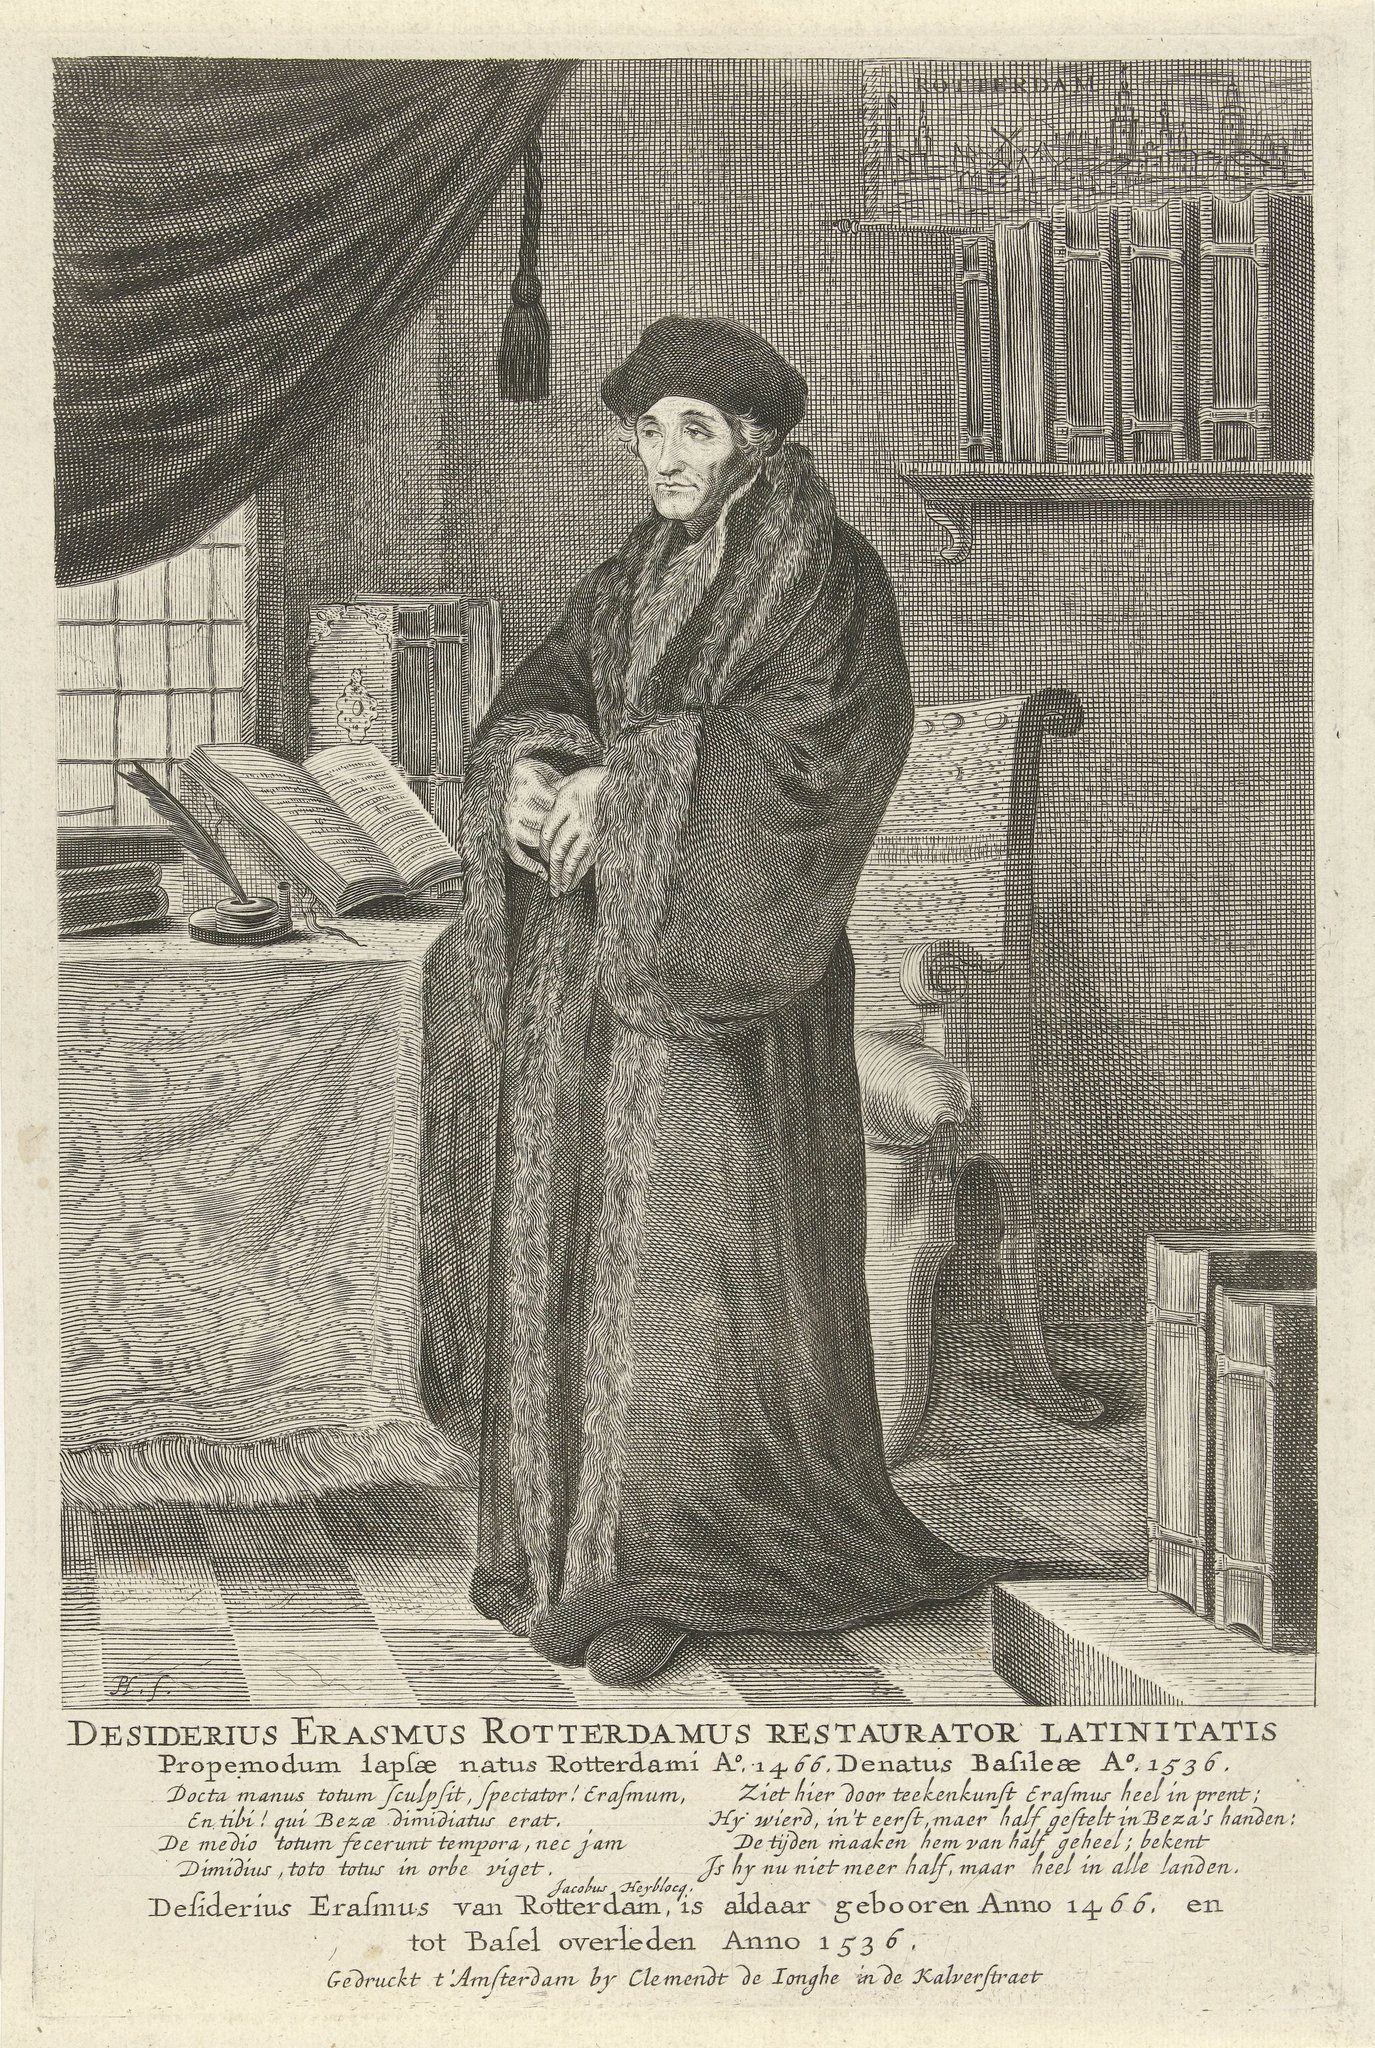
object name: print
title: Desiderius Erasmus Rotterdamus restaurator latinitatis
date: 1640-1670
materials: paper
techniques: engraving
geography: amsterdam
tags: rotterdam, desiderius erasmus, study; 'studiolo'; library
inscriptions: collector's mark: Lugt 240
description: Portret ten voeten uit van Desiderius Erasmus, in het interieur van een studeerkamer. Onder het portret zijn naam en gegevens in twee regels in het Latijn. Daaronder twee kolommen met elk vier regels; links in het Latijn en rechts in het Nederlands. Daaronder de naam en gegevens van de geportretteerde in twee regels in het Nederlands.